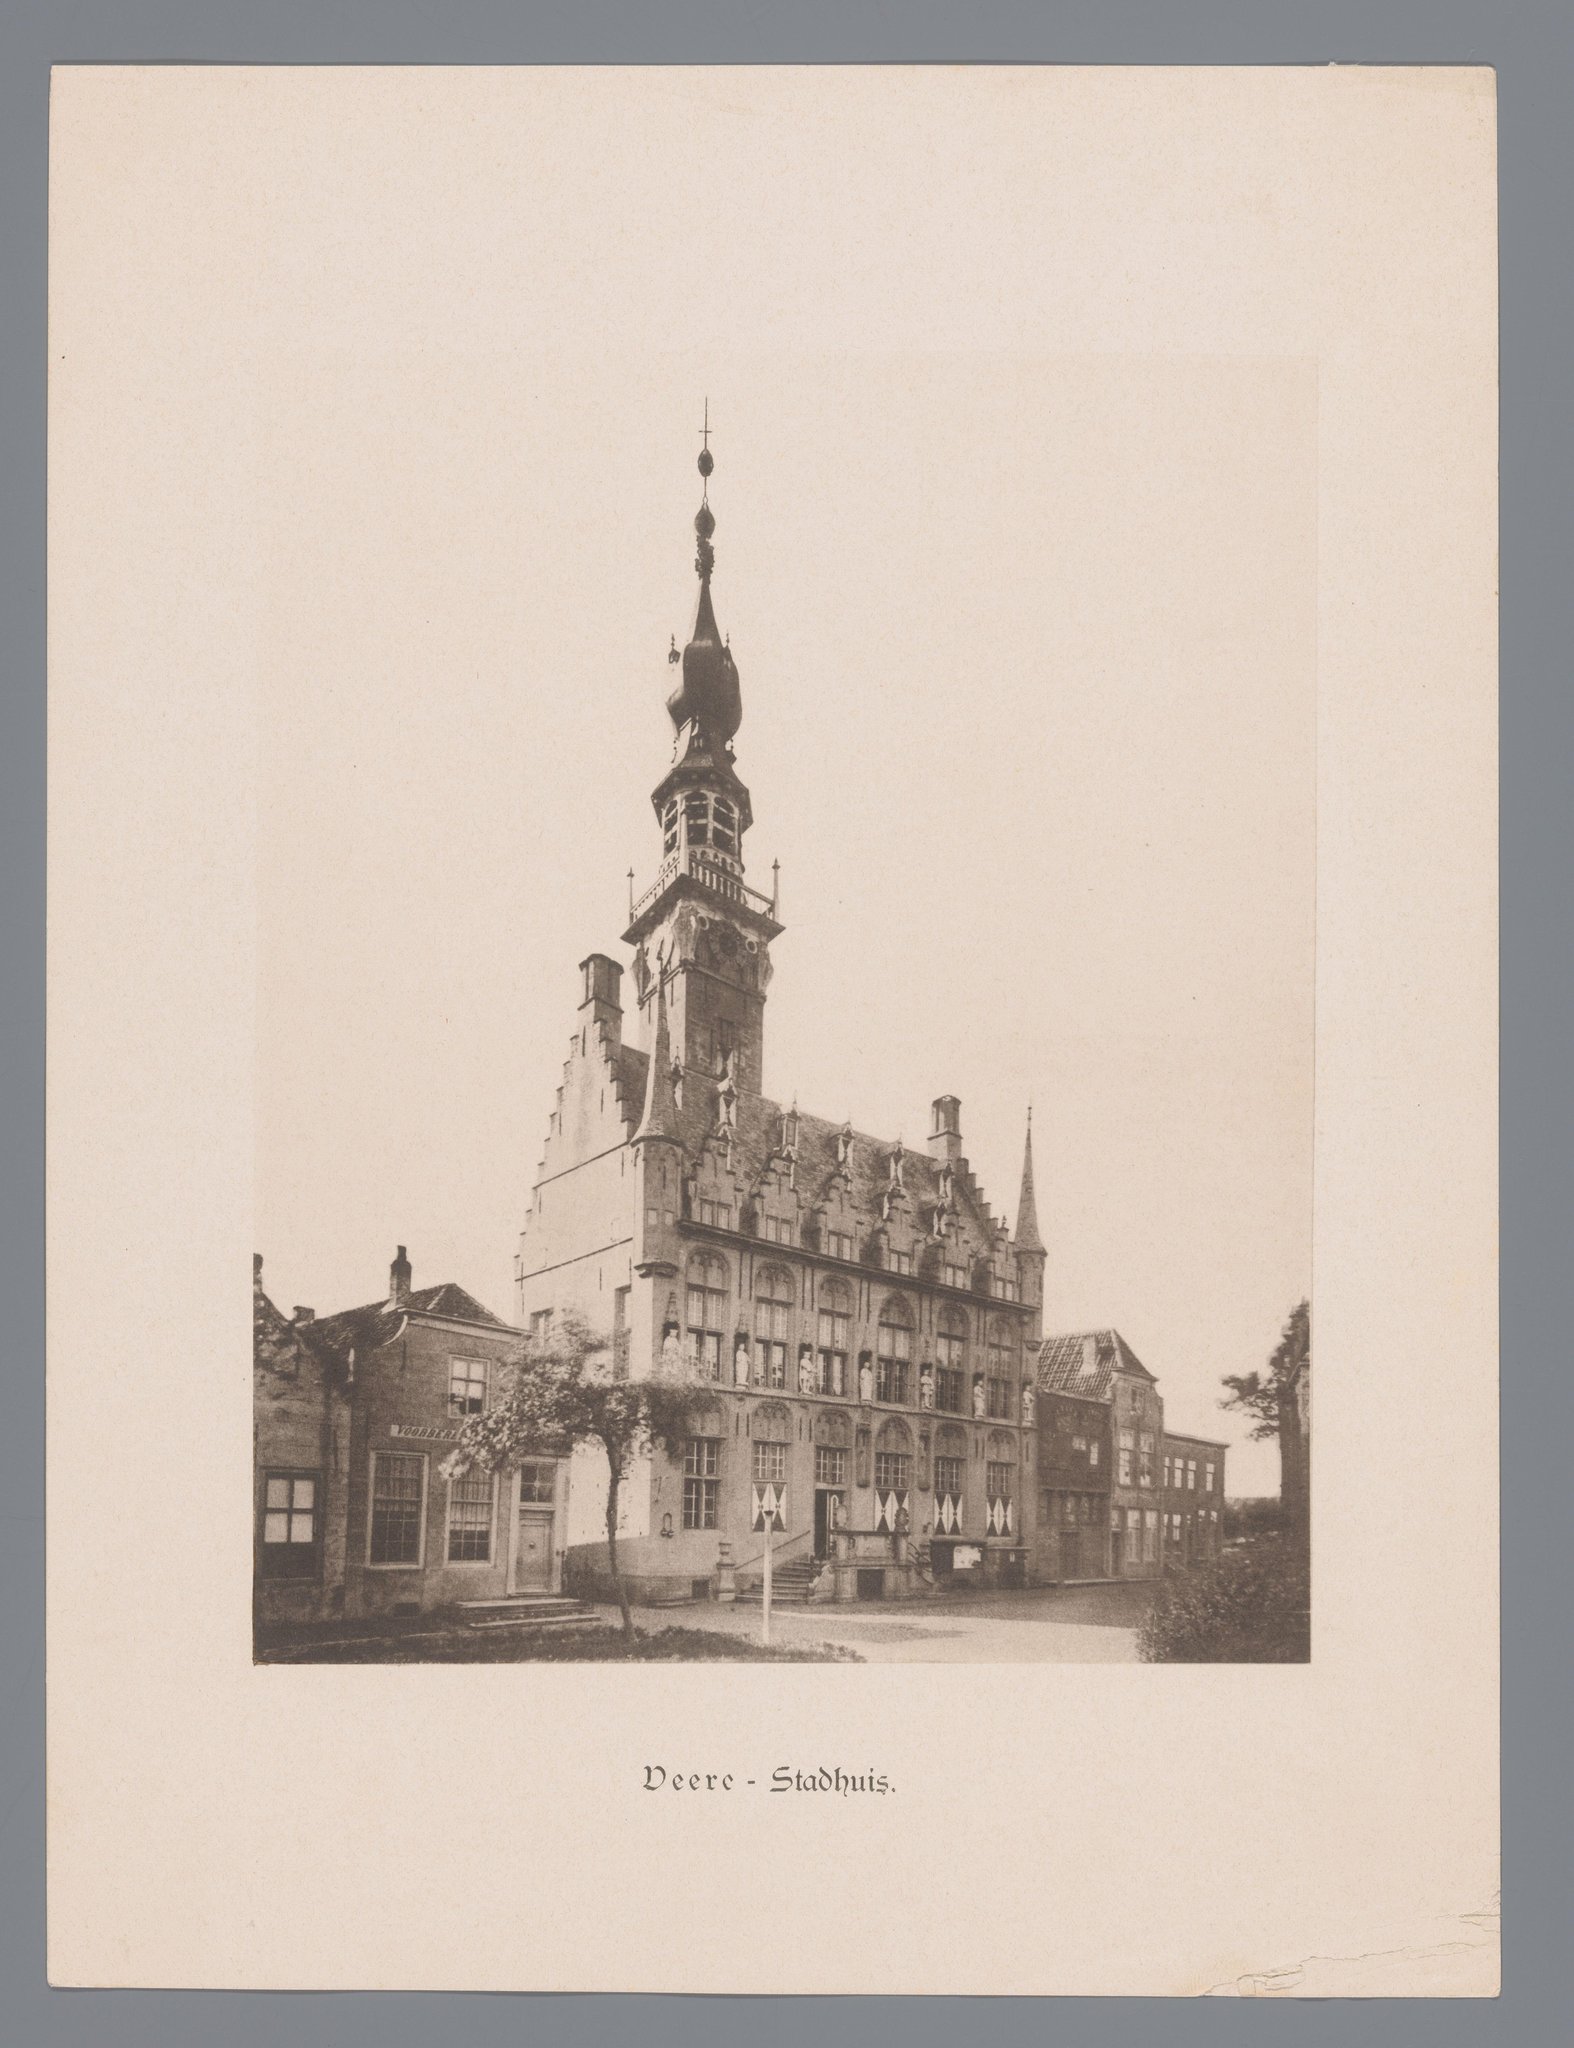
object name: photomechanical print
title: Gezicht op het stadhuis te Veere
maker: Anonymous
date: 1890-1910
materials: paper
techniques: photograph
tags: townhall